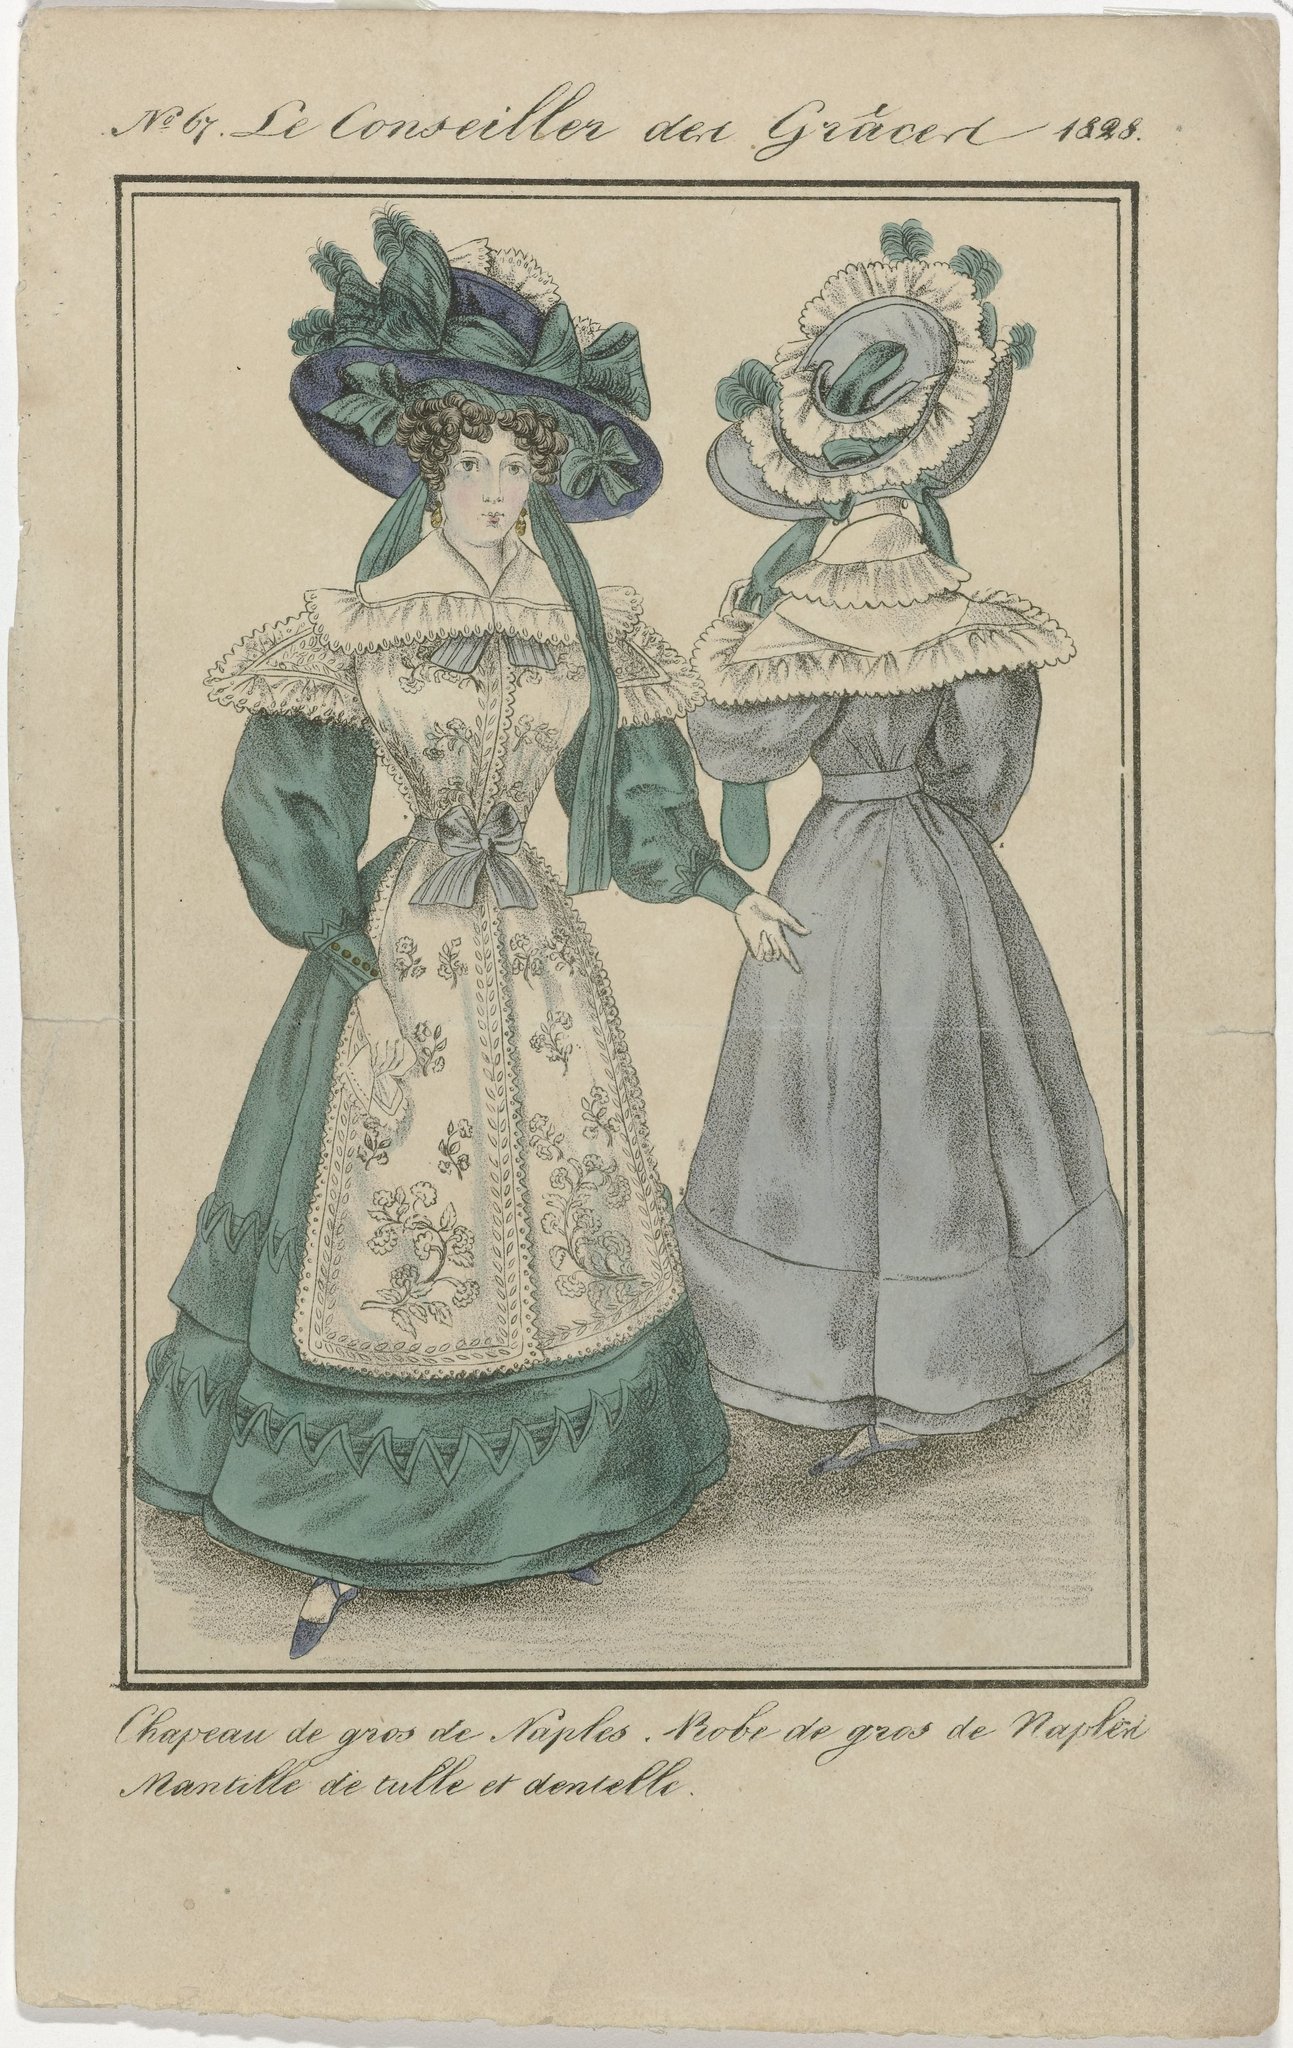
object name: fashion print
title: Le Conseiller des Grâces, 1828, No. 67: Chapeau de gros de Naples (...)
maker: Anonymous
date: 1828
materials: paper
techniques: hand coloring, lithograph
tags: ear-rings (+ women's clothes), handkerchief (+ women's clothes), lace (+ women's clothes), clothing for the upper part of the body (mantelet) (+ women's clothes), clothing for the upper part of the body (mantelet) (+ lace used for clothes), fashion plates, head-gear: hat (+ women's clothes), dress, gown (+ women's clothes), neck-gear ~ clothing (+ women's clothes)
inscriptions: title: ‘No. 67. Le Conseiller des Grâces 1828’, caption: ‘Chapeau de gros de Naples. Robe de gros de Naples Mantille de tulle et dentelle.’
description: Hoed van 'gros de Naples'. Japon van 'gros de Naples'. 'Mantille' van tule en kant. Verdere accessoires: oorbellen, gestrikt ceintuur, zakdoek, platte schoenen. Prent uit het modetijdschrift Le Conseiller des Grâces (1823 -1830).